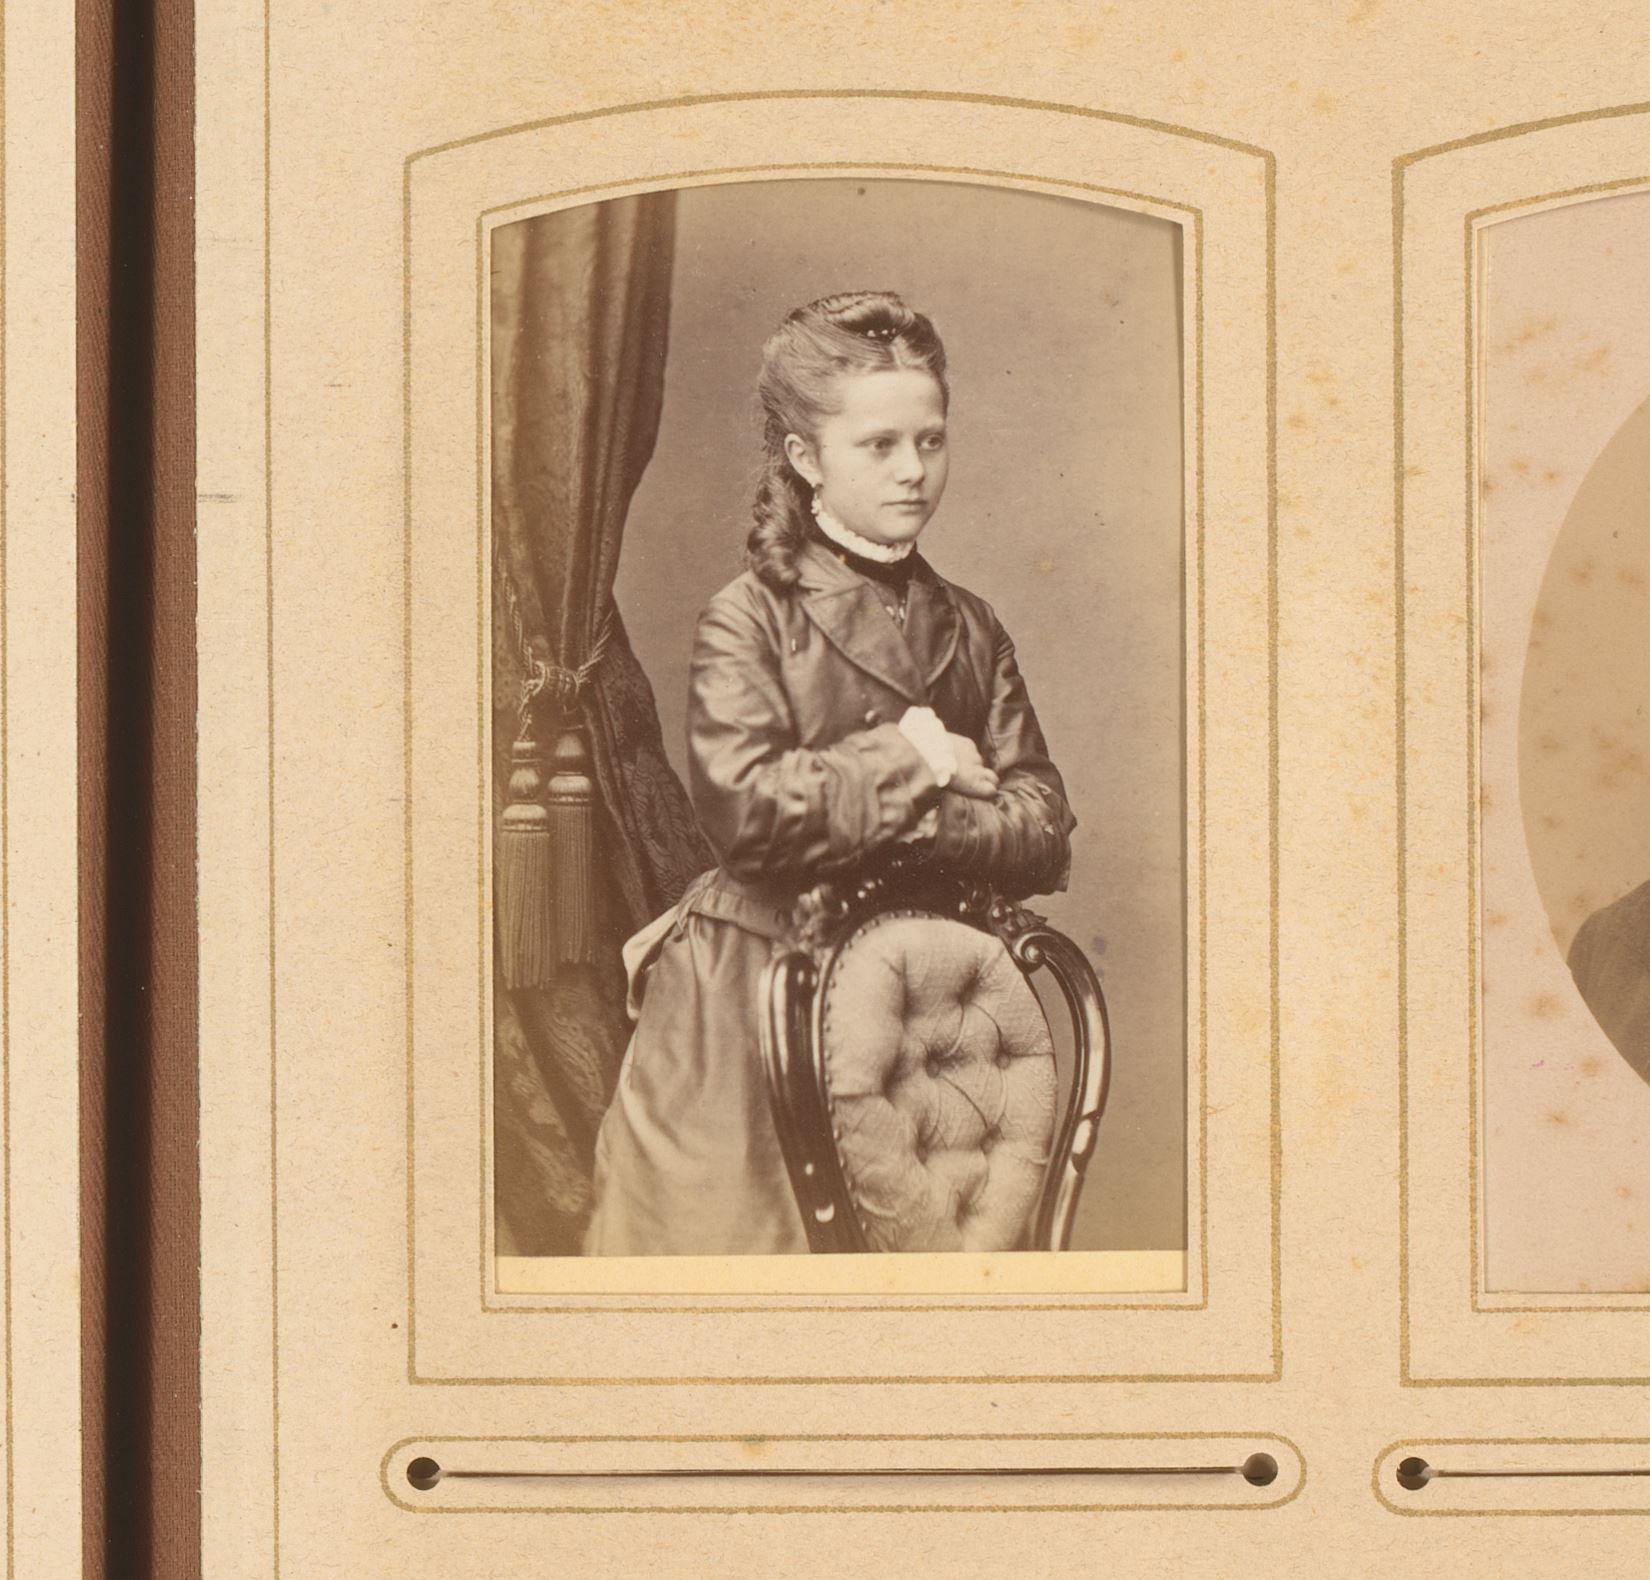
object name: photograph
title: Portret van een meisje, leunend op de leuning van een stoel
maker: albert greiner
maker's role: fotograaf, fotostudio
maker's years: 1833-1890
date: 1861-1874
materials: cardboard, photographic support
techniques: albumen print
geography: amsterdam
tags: historical persons - bb - woman, girl (child between toddler and youth), chair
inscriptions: inscription: ‘A. Greiner/ Photograf/ Amsterdam/ Nieuwendijk L. 89.’